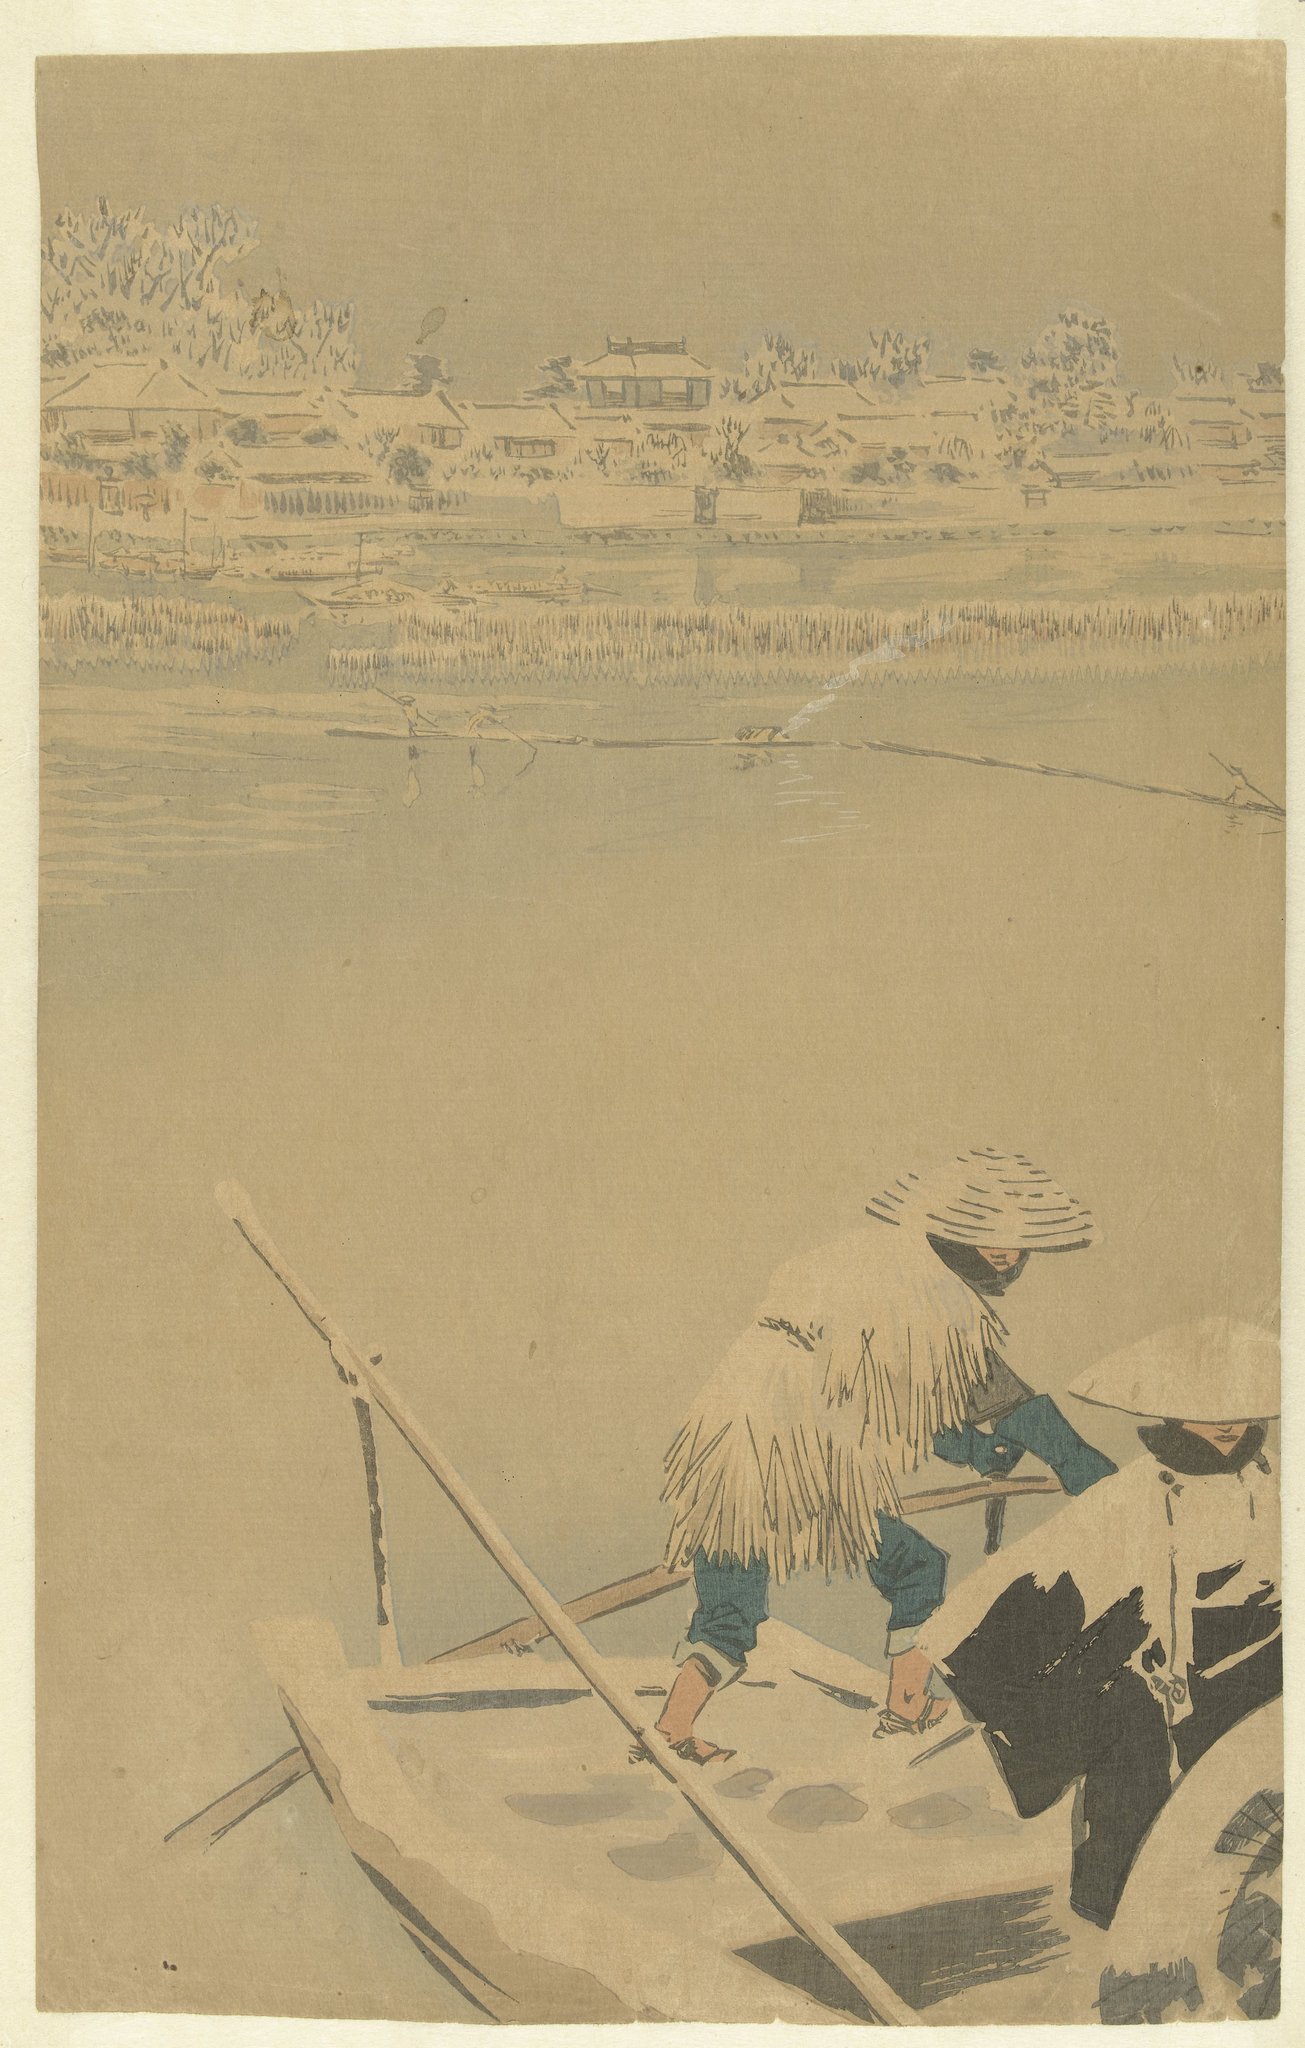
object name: print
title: Tokyo meisho shinkei no uchi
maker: kobayashi kiyochika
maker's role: print maker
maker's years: 1847-1915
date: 1896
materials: paper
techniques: woodcut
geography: japan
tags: landscapes (+ landscape with figures, staffage), boat propelled by man or animal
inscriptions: collector's mark: Lugt 2228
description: Sneeuwlandschap; veerboot met twee mannen op de rivier de Sumida. Middelste blad van een drieluik.